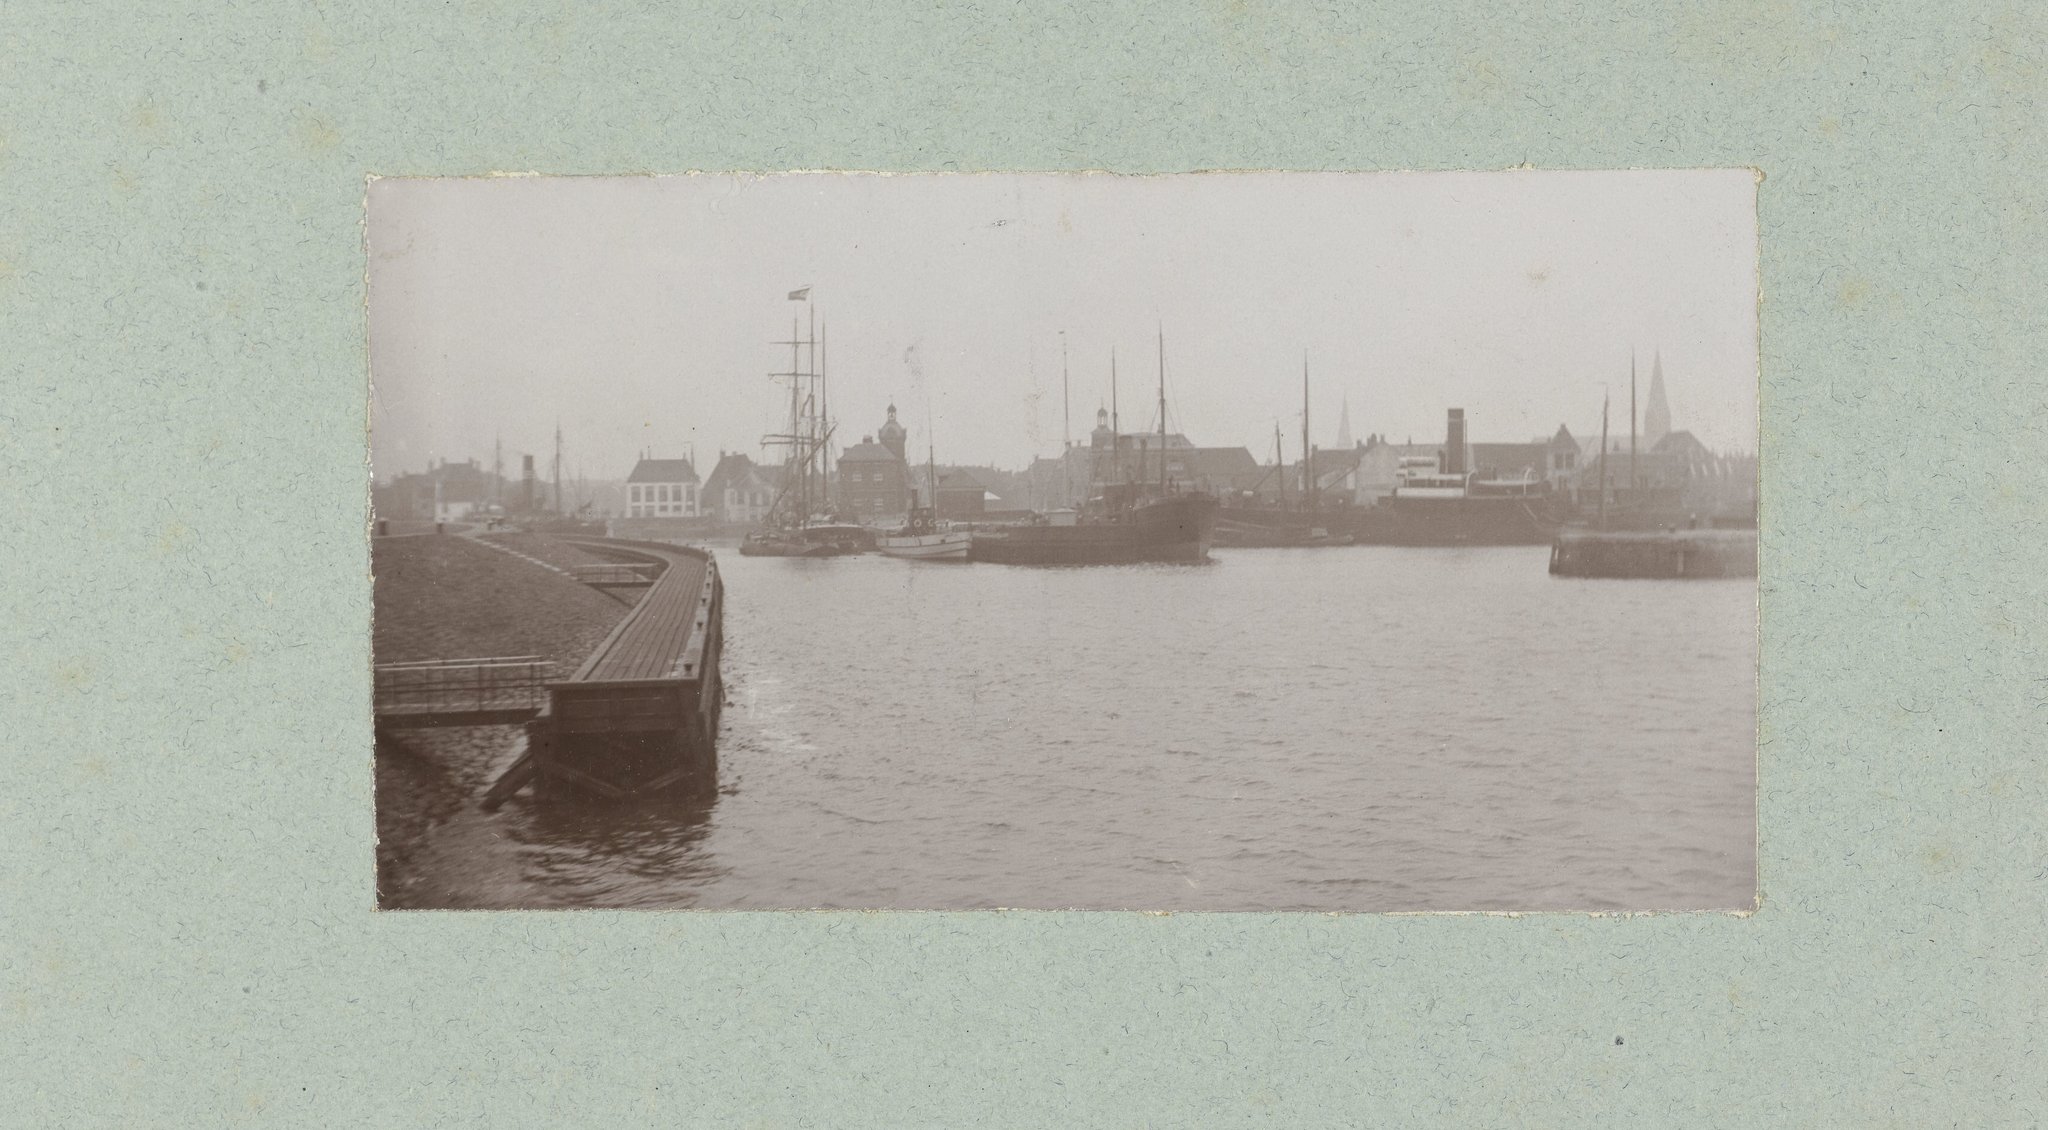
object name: photograph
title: Havengezicht in Harlingen met stoom- en zeilschepen.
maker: frits freerks fontein fz.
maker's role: fotograaf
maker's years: 1882-1928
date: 1903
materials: cardboard, paper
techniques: gelatin silver print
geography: netherlands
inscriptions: caption: ‘Harlingen 1905’